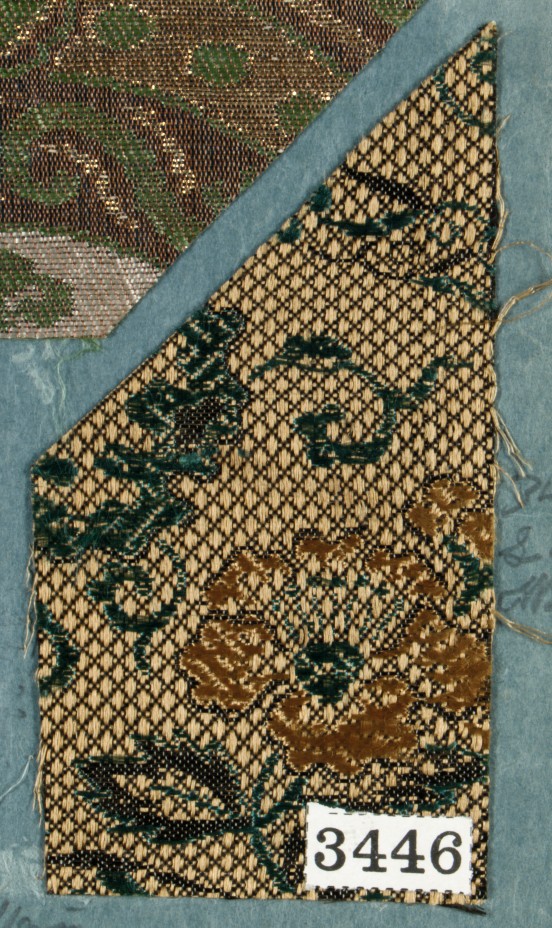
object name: sample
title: Textile Sample from Sample Book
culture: japanese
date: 1801-1900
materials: silk